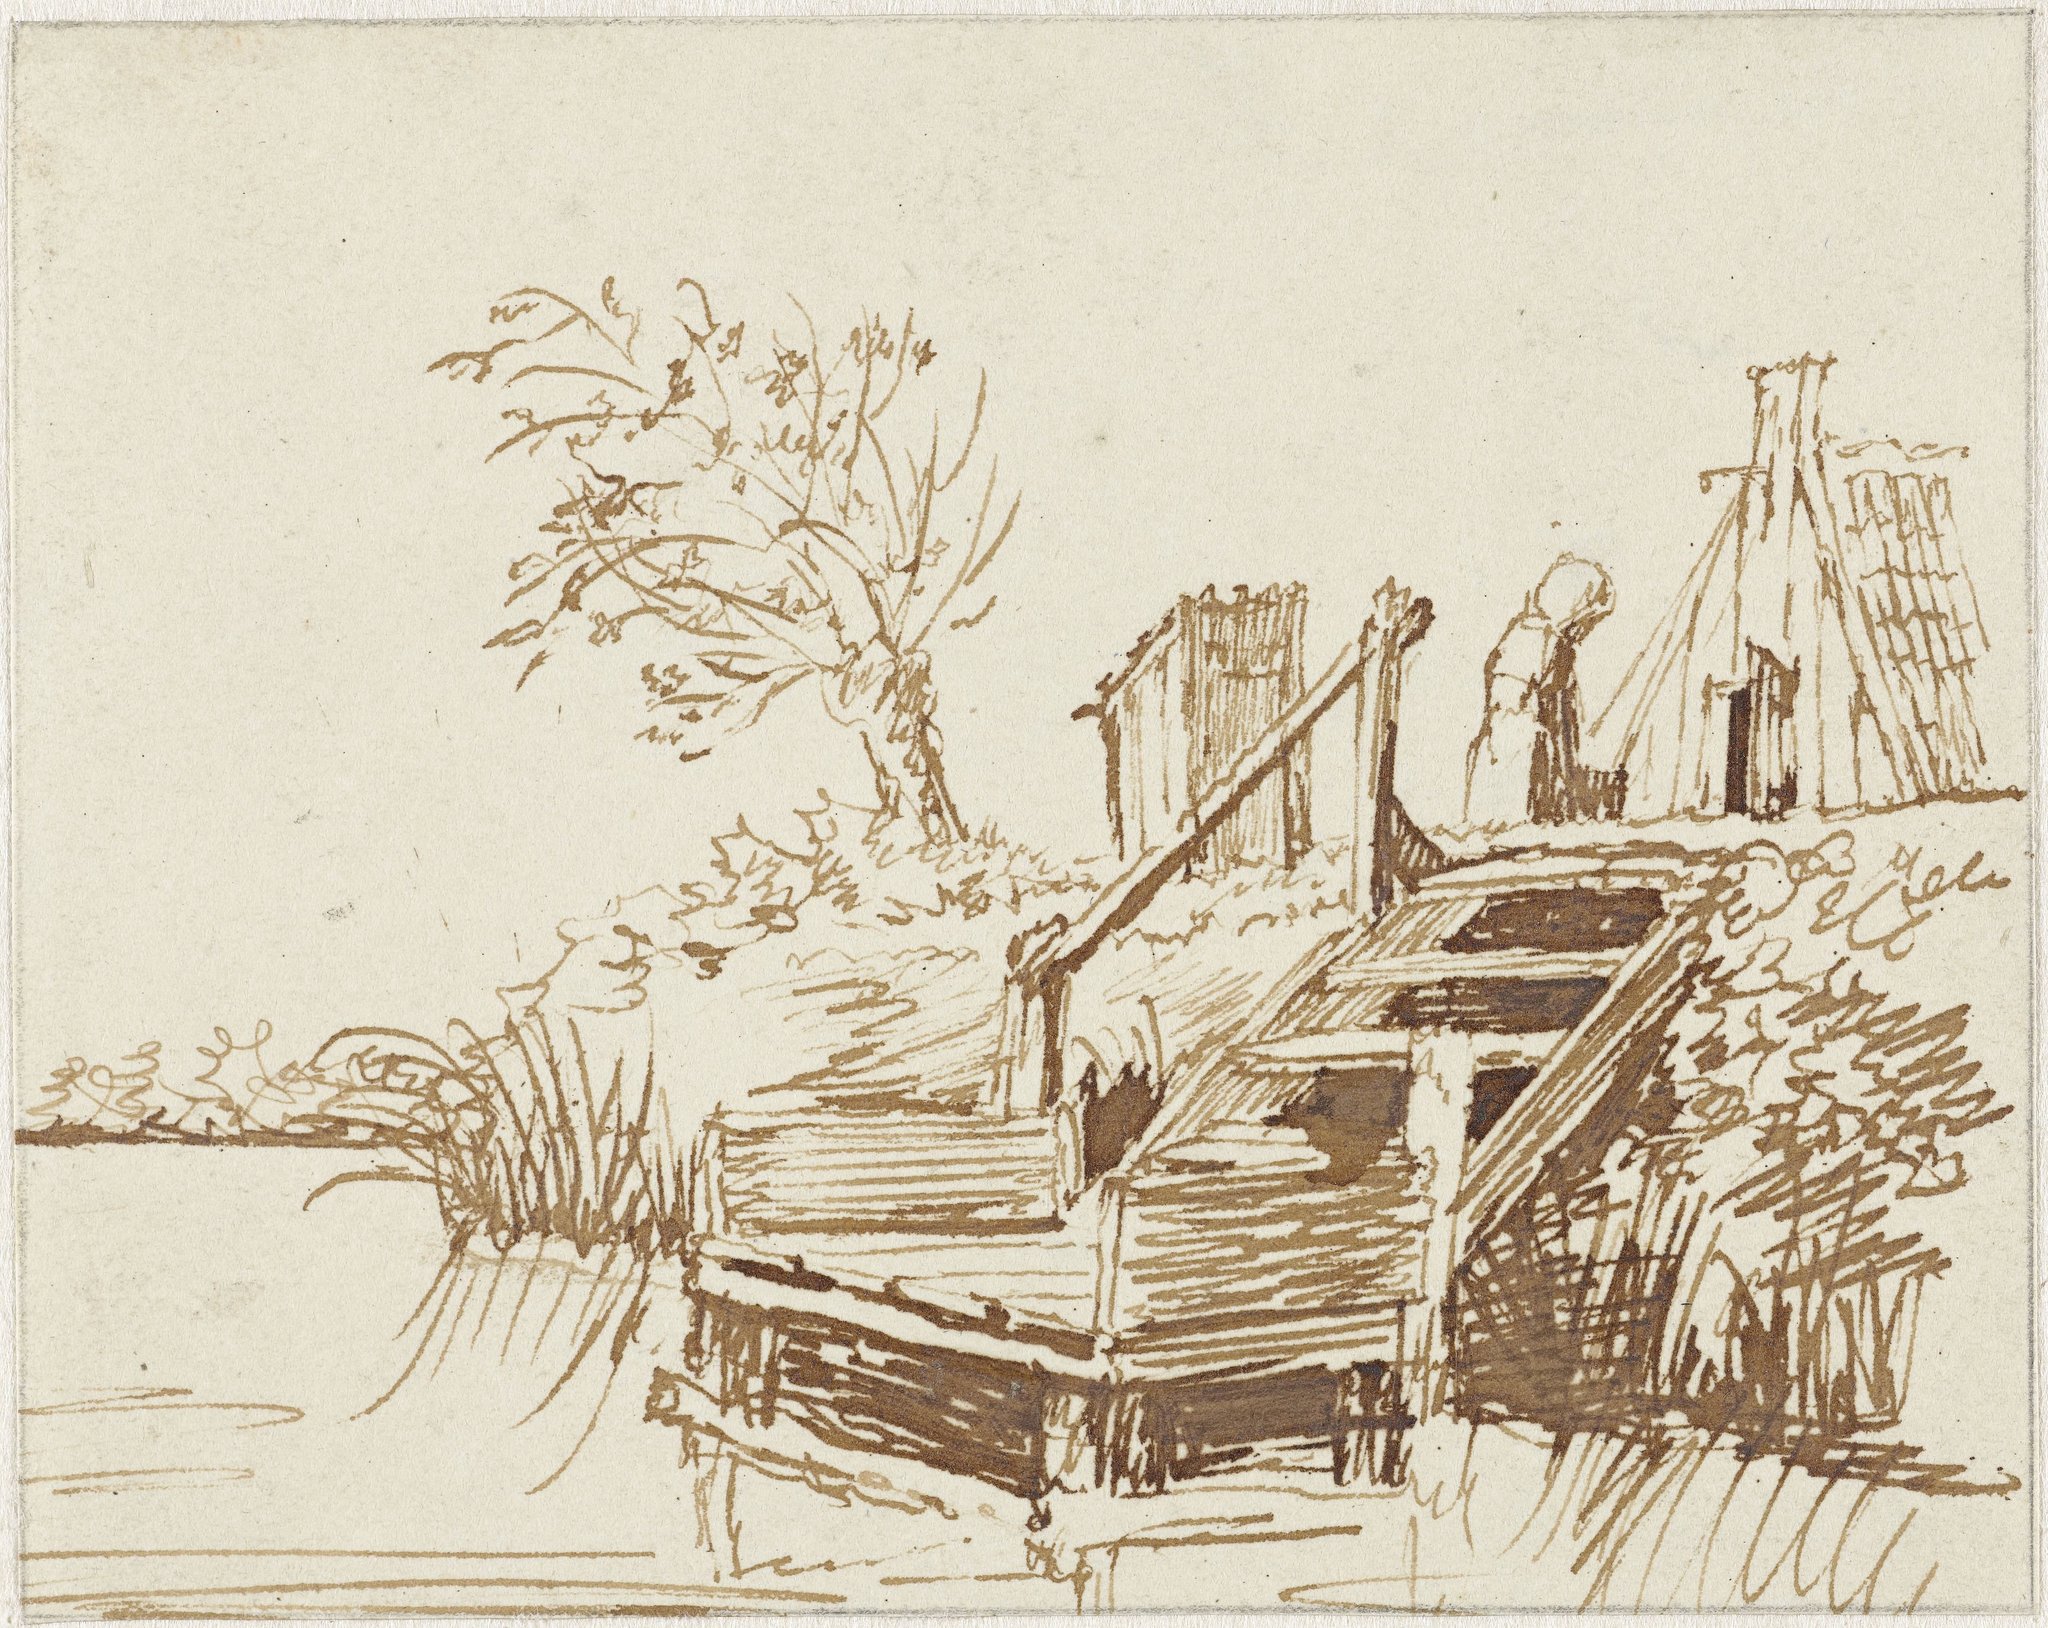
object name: design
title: De trap aan het water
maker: gerrit lamberts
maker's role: bookseller, draughtsman, print maker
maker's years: 1776-1850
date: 1786-1850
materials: chalk, ink, paper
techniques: pen